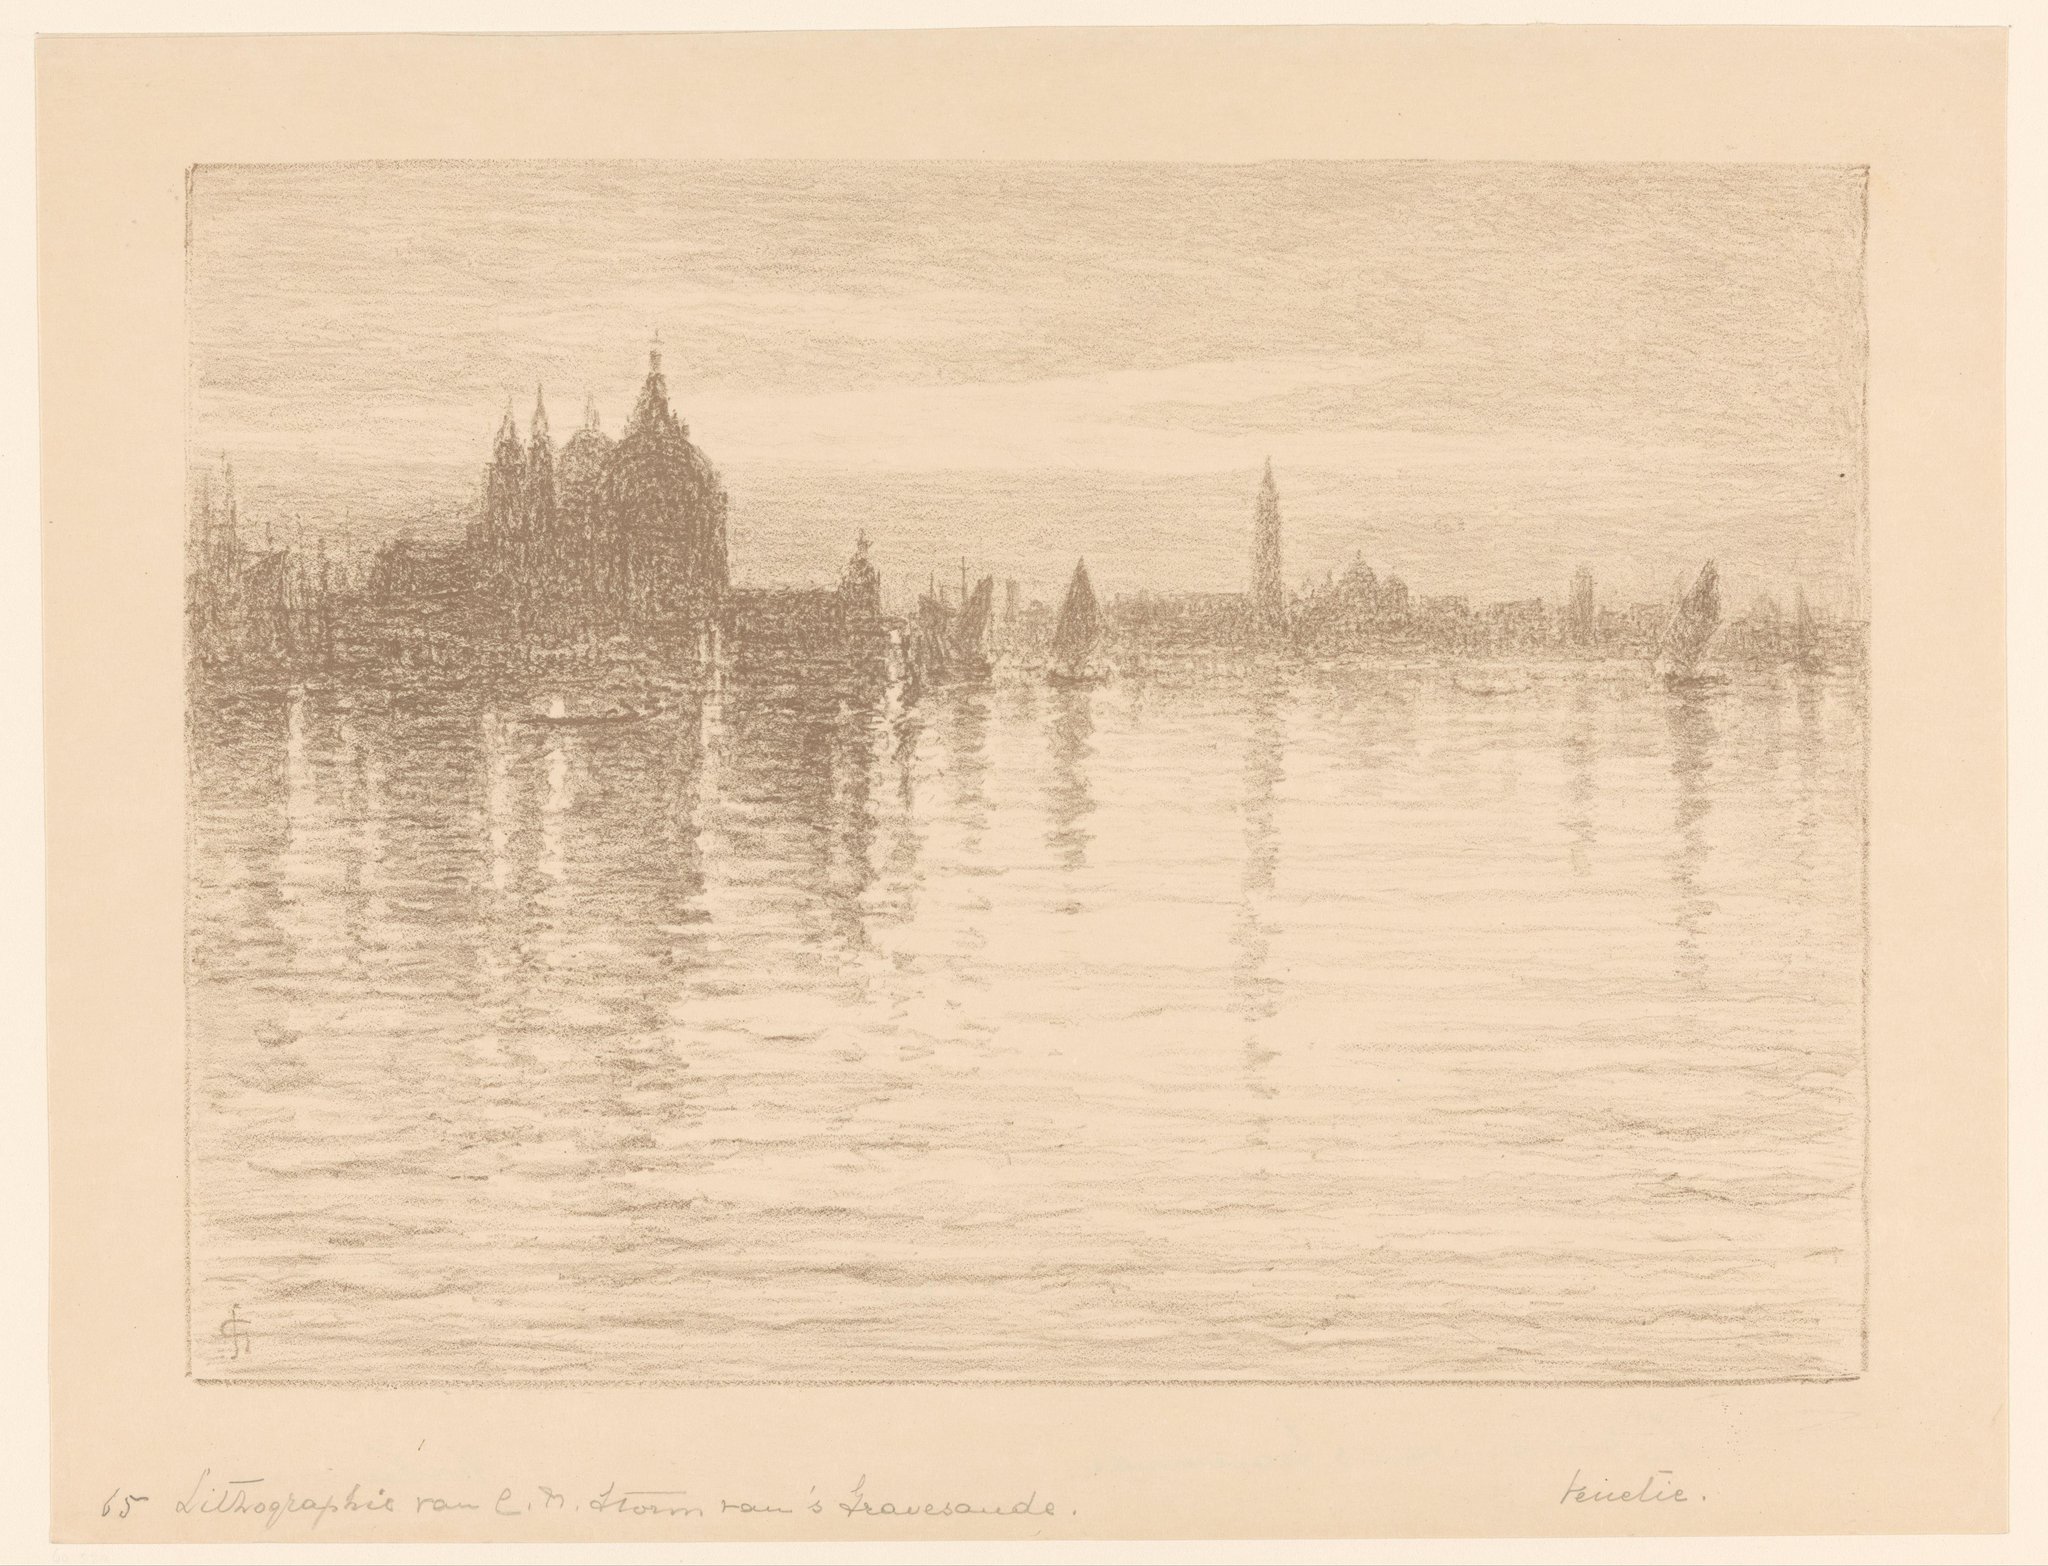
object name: print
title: Gezicht op de Basiliek van Santa Maria della Salute vanaf het water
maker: carel nicolaas storm van s-gravesande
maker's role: draughtsman, print maker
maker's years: 1841-1924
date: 1851-1924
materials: paper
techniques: lithograph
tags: parts of church exterior and annexes: dome, canals, waters (in city)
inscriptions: number: ‘65’, collector's mark: Lugt 2228, inscription: ‘Lithographie van C.N. Storm van 's Gravesande. Venetië.’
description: Mogelijk vermeld in: Storm van 's-Gravesande, Charles. Catalogue des eaux-fortes et lithographies. New York: s.n., 1903, of in een onbekende latere uitgave van het manuscript. Vermoedelijk vermeld als catalogusnummer 65.